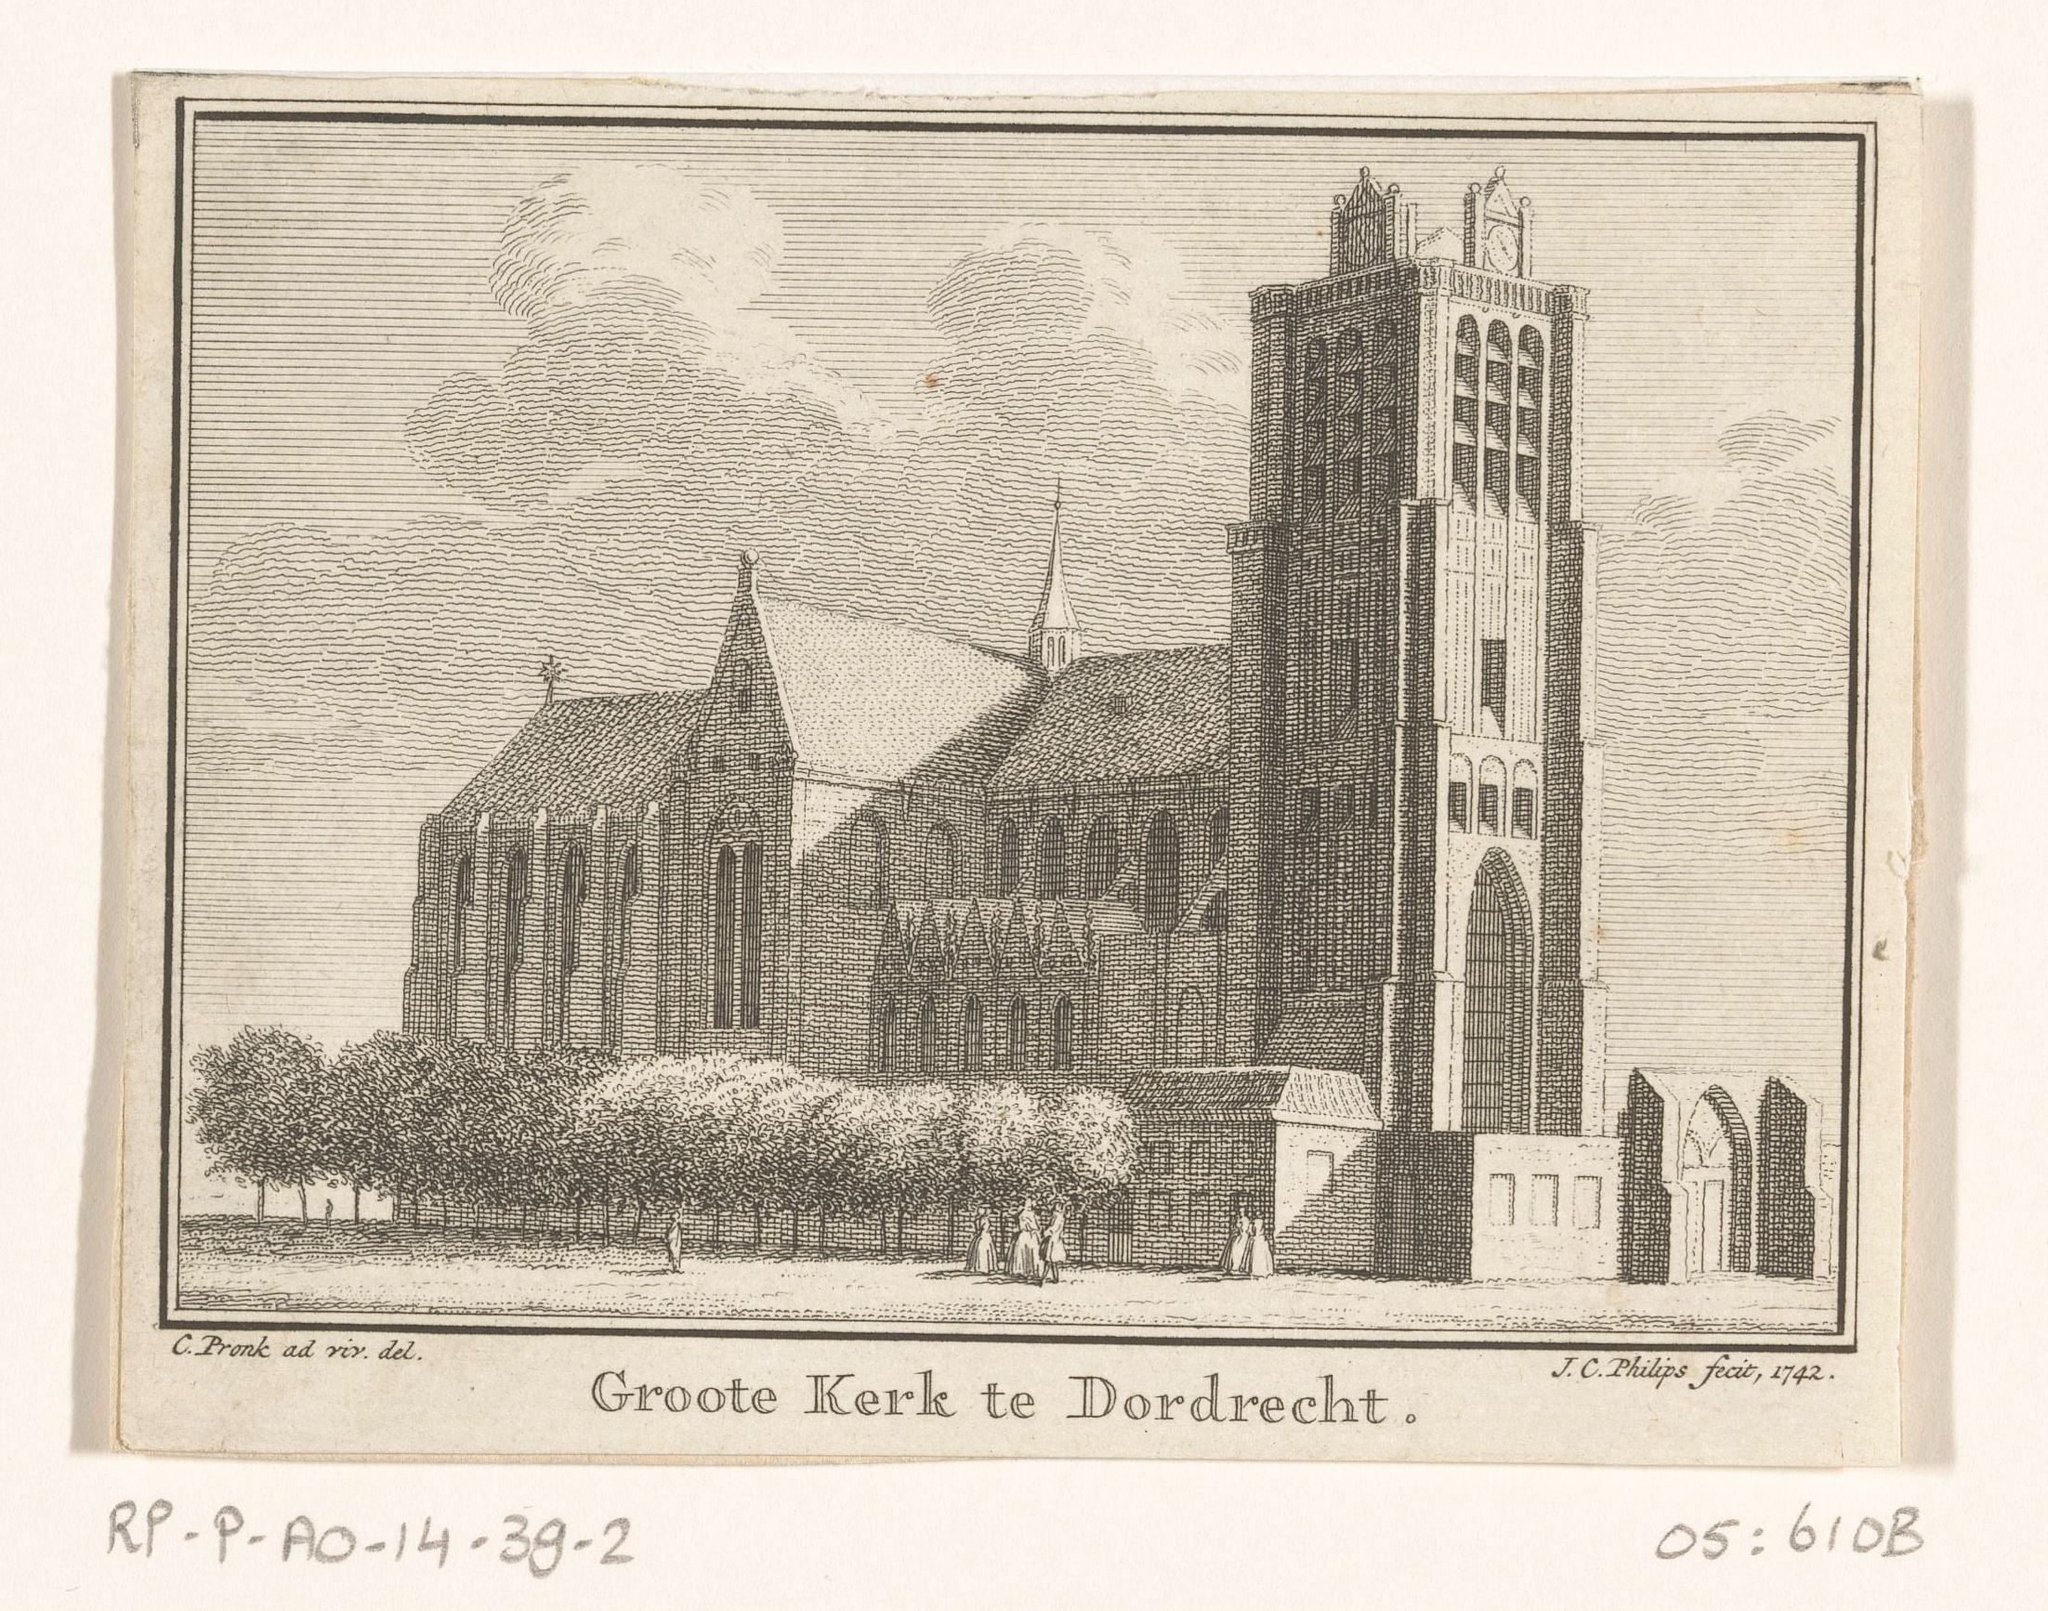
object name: print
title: Groote Kerk te Dordrecht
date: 1742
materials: paper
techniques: etching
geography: amsterdam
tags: grote of onze-lieve-vrouwekerk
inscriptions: collector's mark: Lugt 195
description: Gezicht op de Grote of Onze-Lieve-Vrouwekerk te Dordrecht. Links van de kerk een rij bomen en enkele figuren.